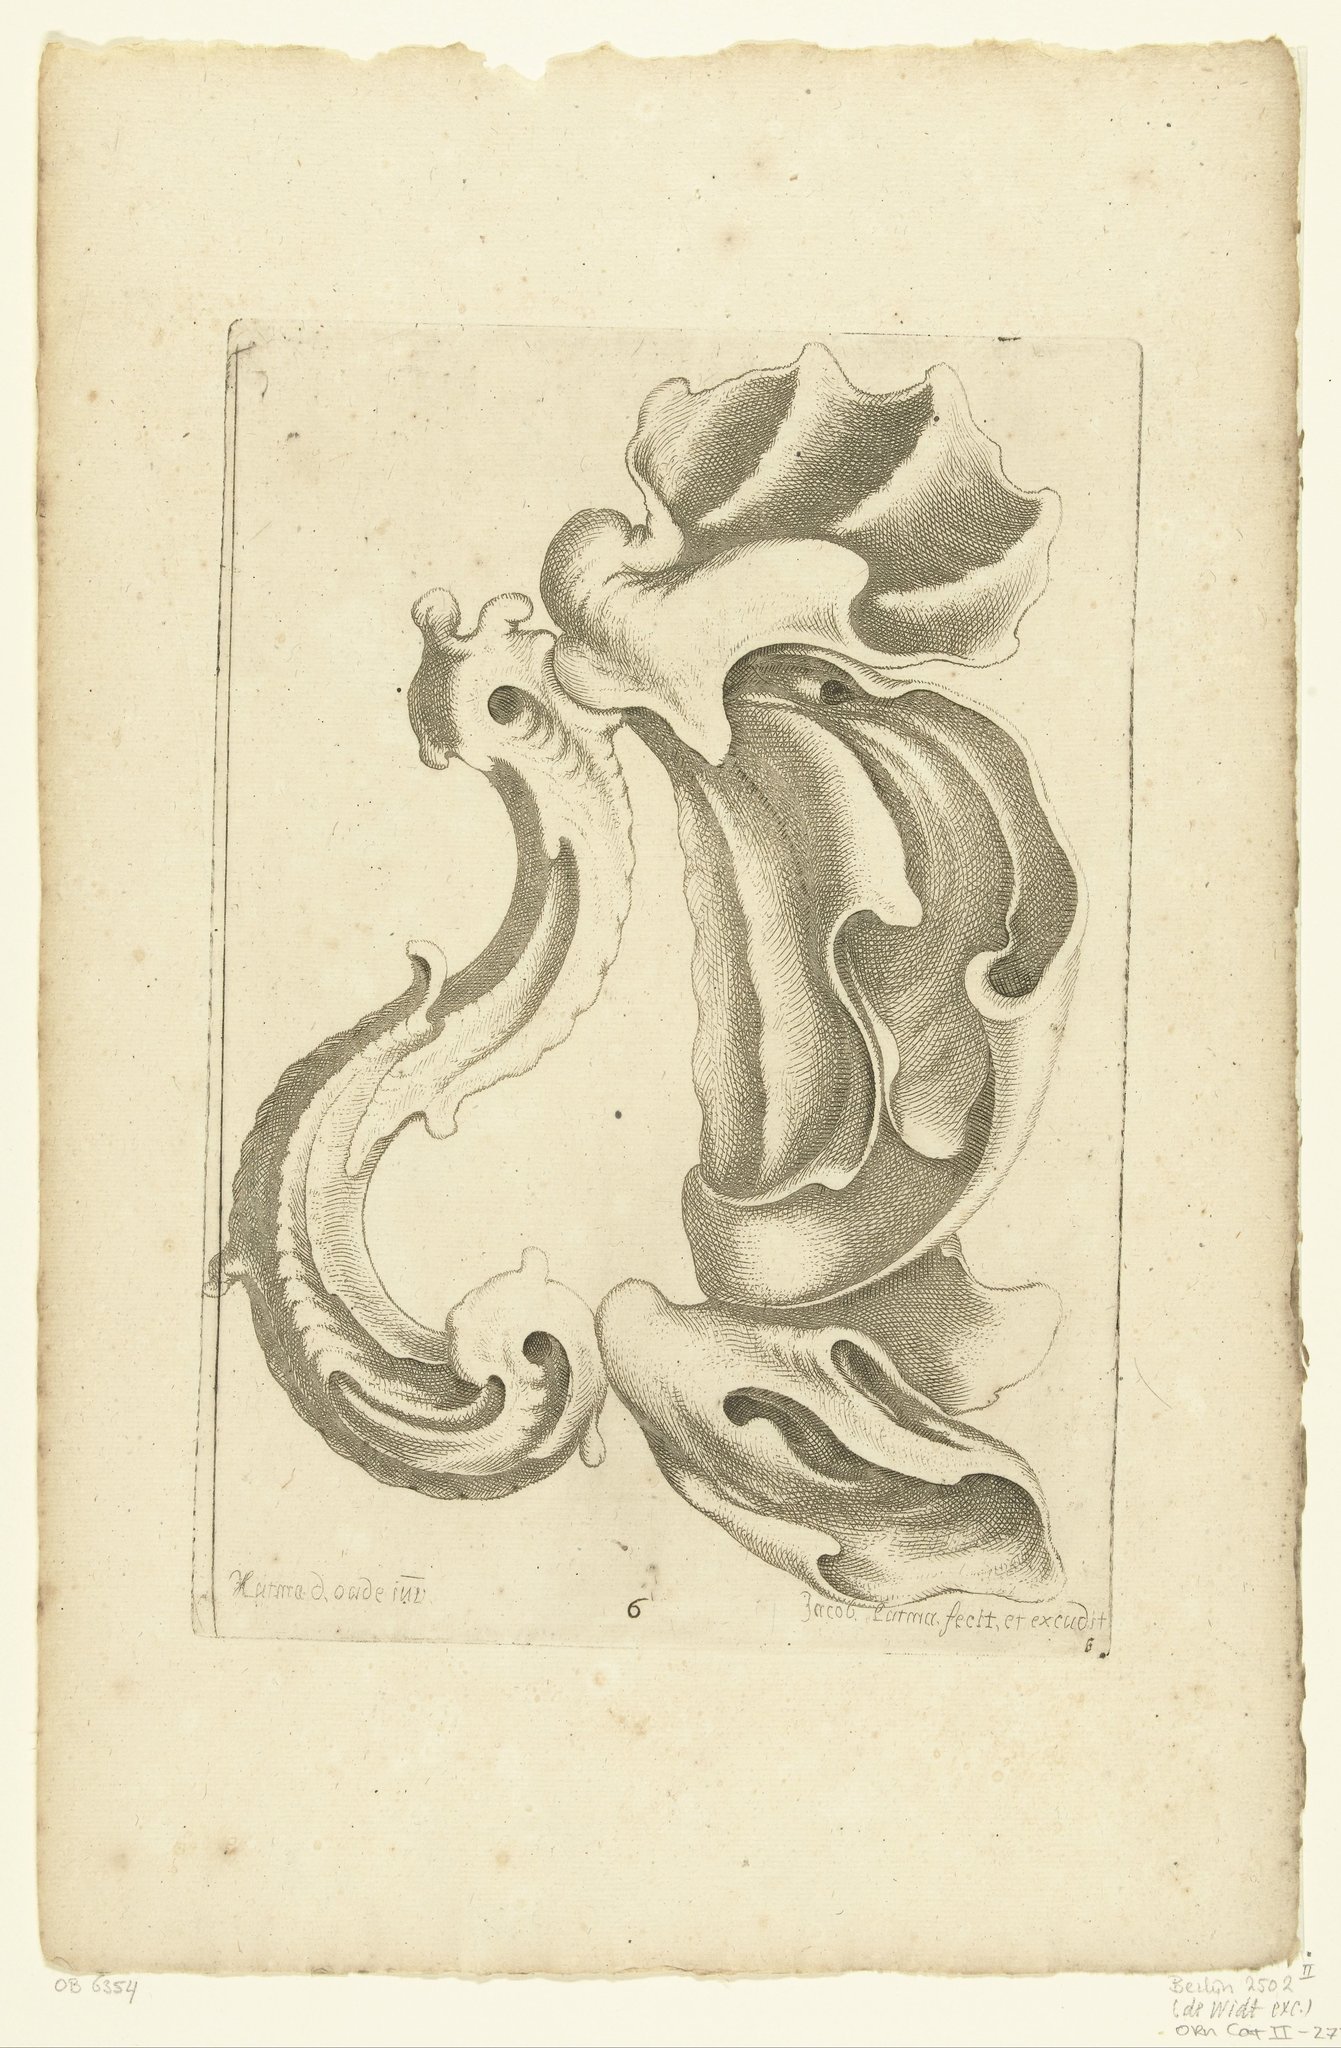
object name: ornament print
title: Cartouche met schedel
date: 1654-1678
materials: paper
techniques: engraving, etching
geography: amsterdam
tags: (human) skull, ornament ~ cartouche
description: Cartouche met twee compartimenten, de bovenste in een masker, met ertussenin een schedel. Prent uit tweede editie van serie.